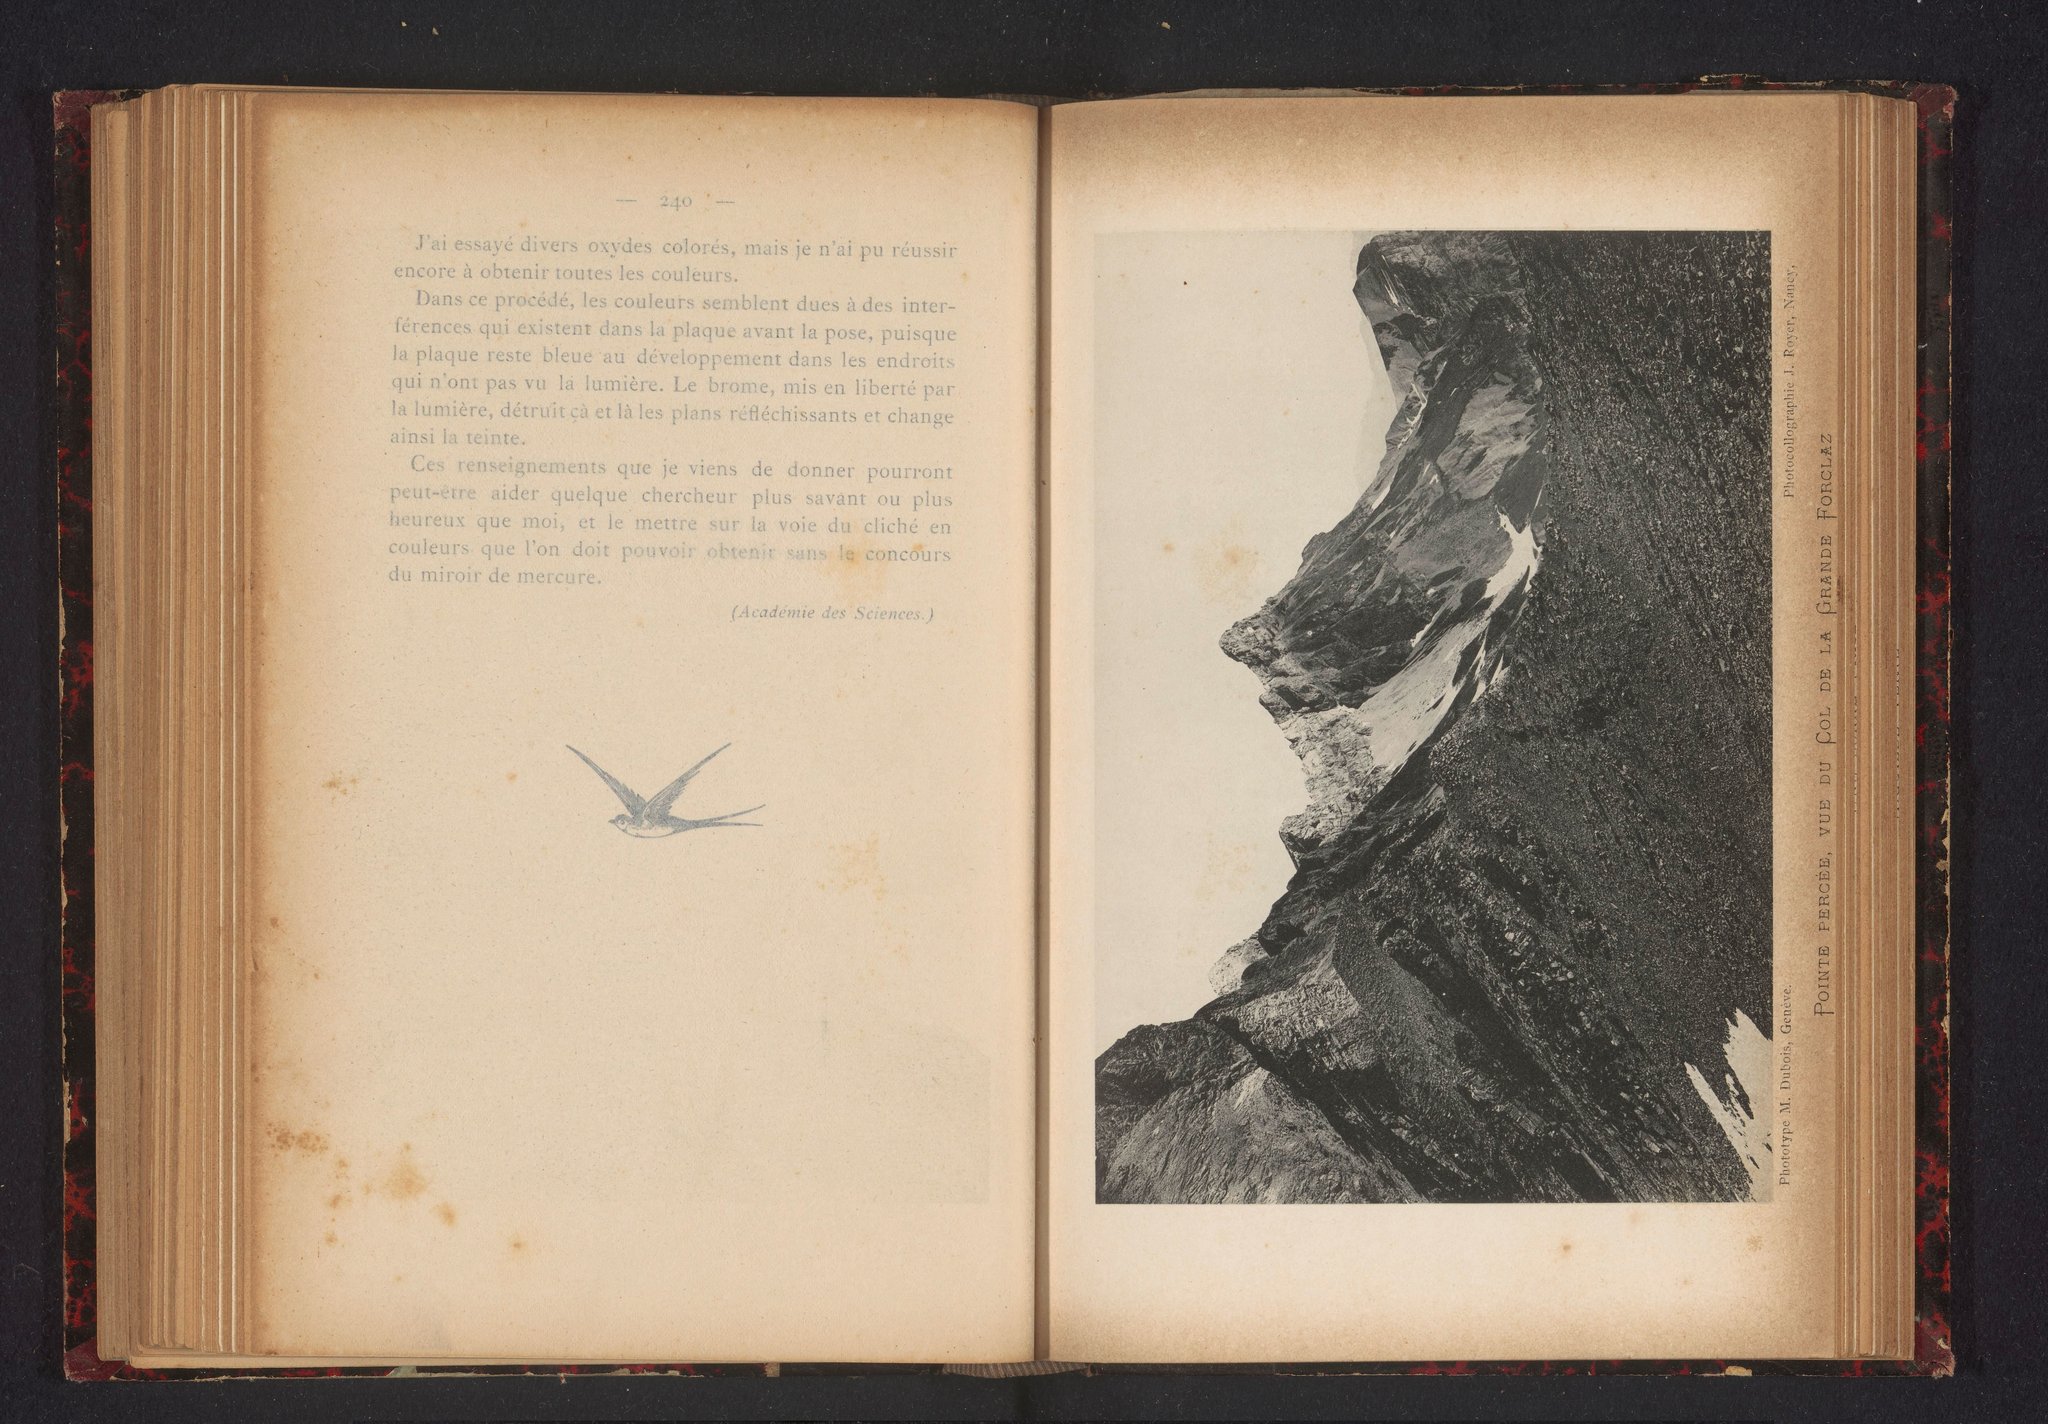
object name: photomechanical print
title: Pointe percée, vue du Col de la Grande Forclaz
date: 1892-1897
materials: paper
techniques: photograph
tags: mountains